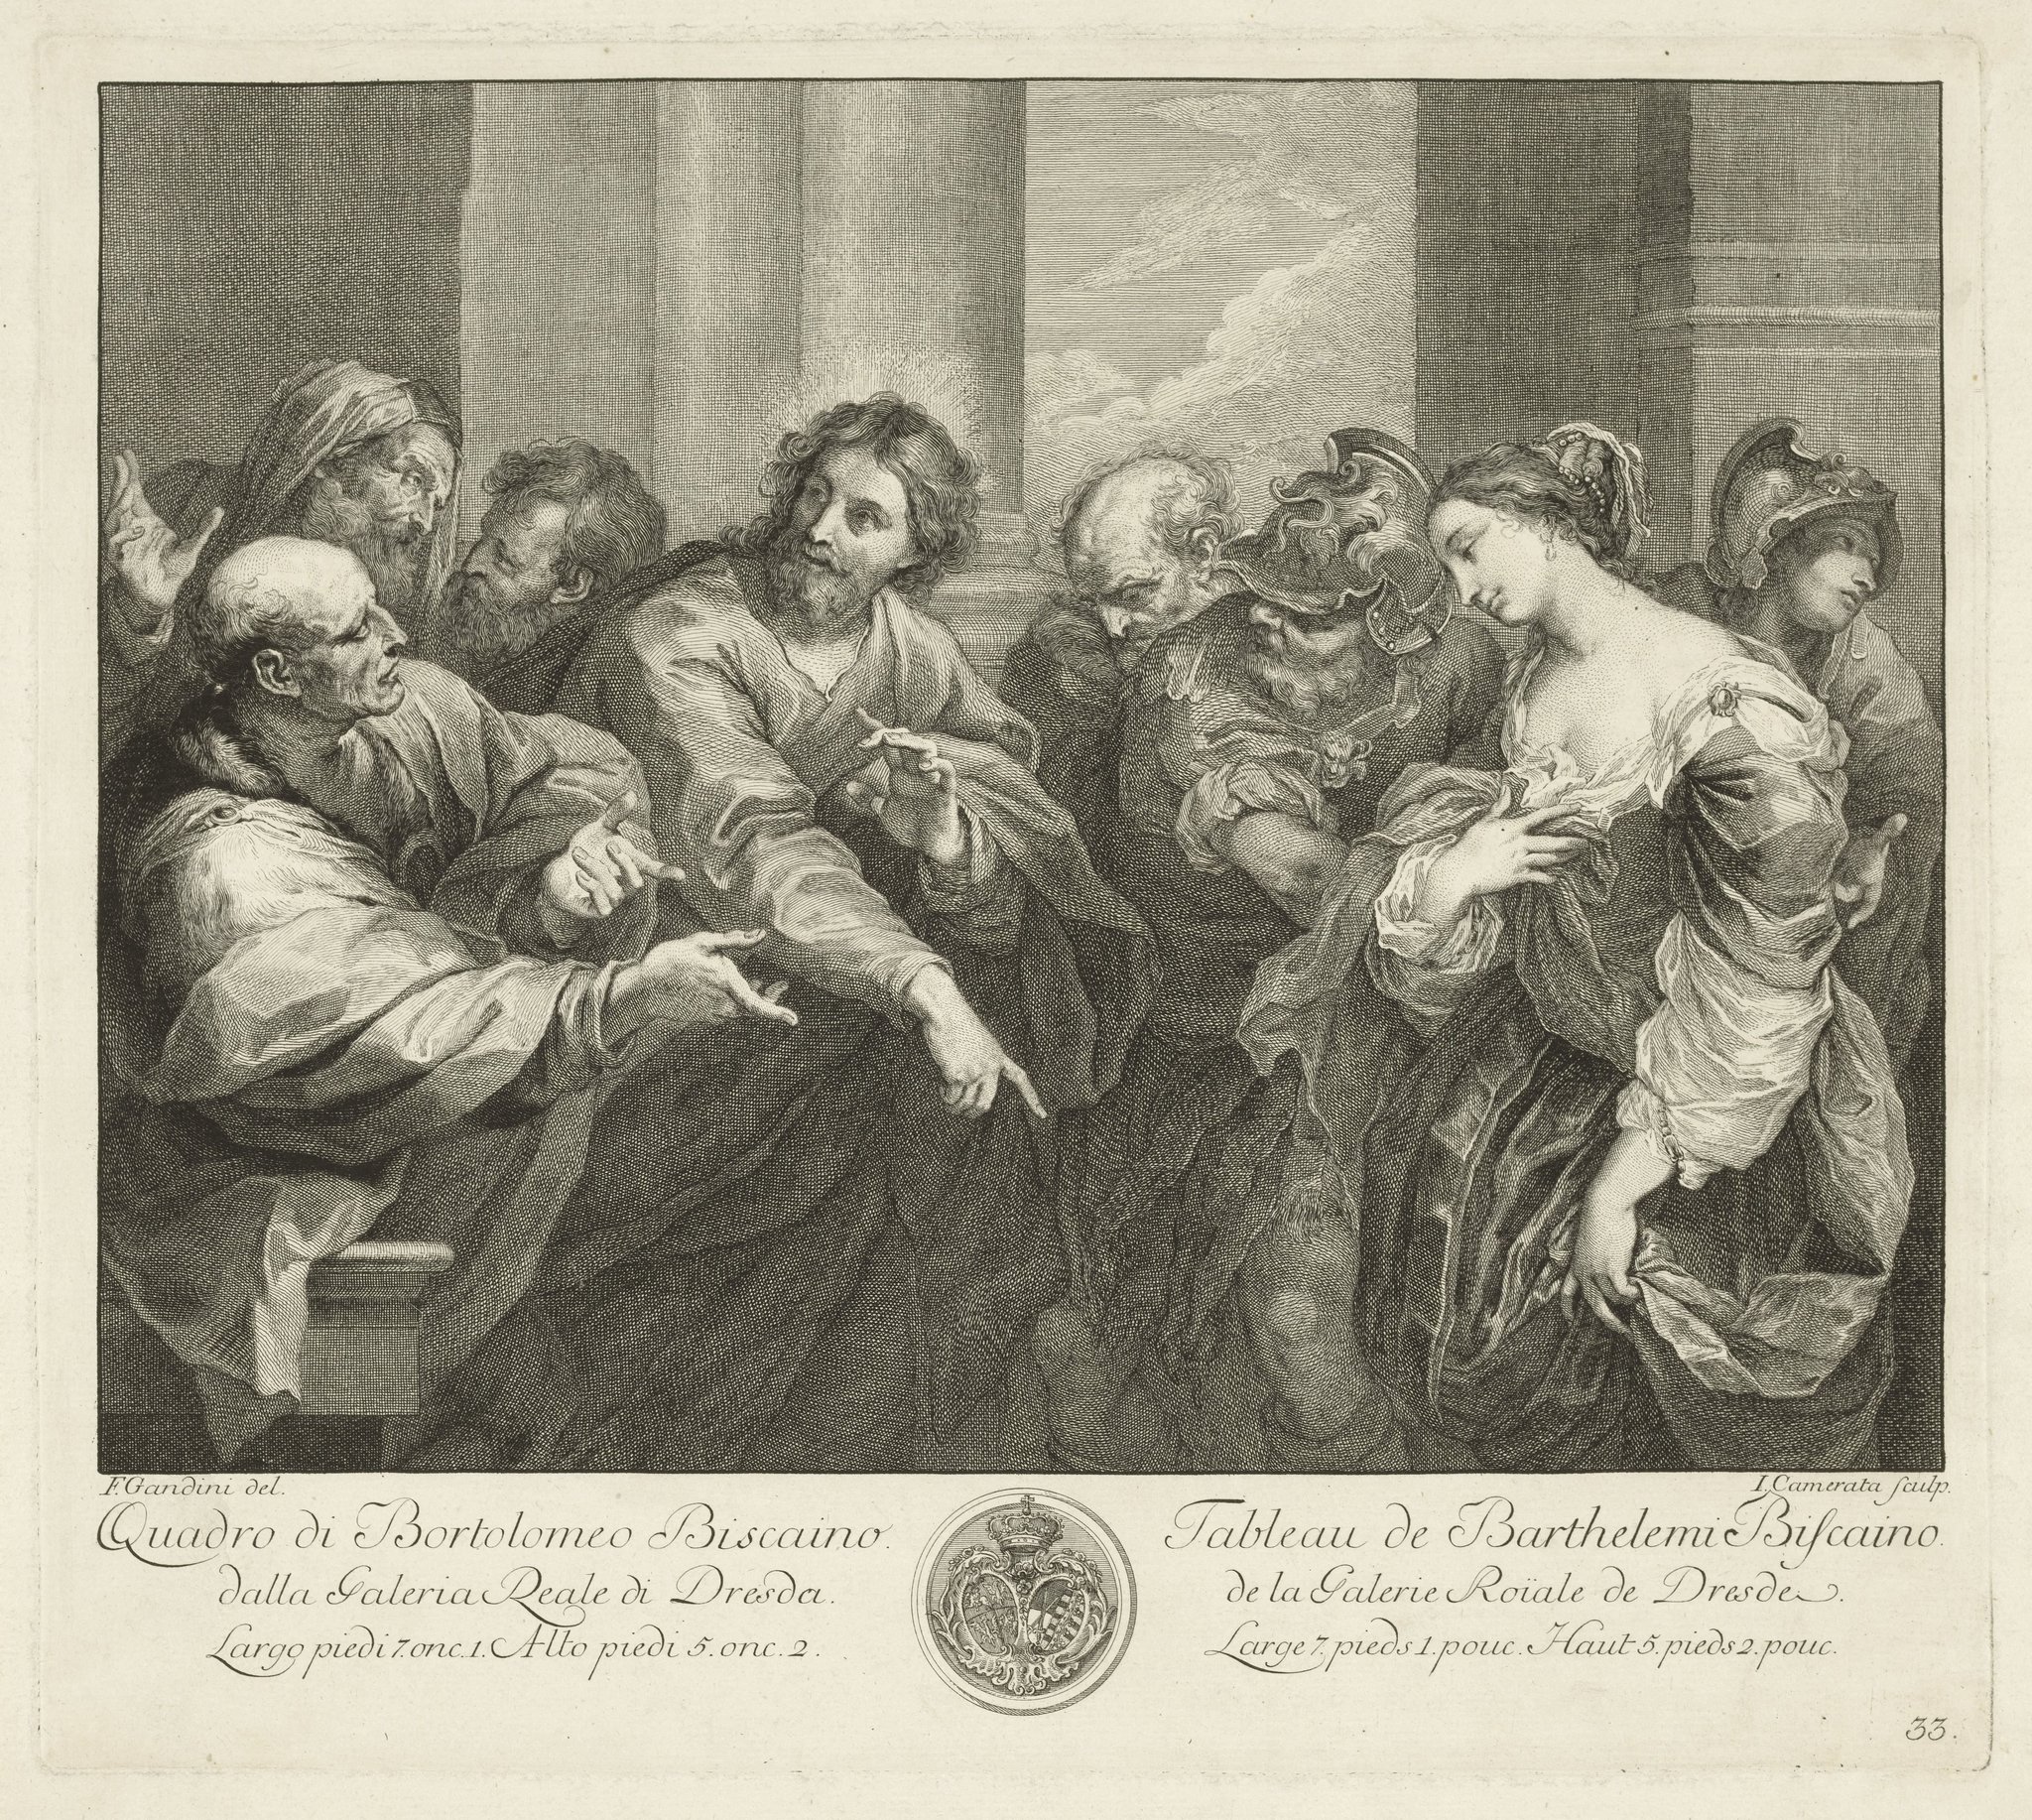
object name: print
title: Christus en de overspelige vrouw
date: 1728-1803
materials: paper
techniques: engraving, etching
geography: italy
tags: pharisees bring a woman accused of adultery before christ (john 8:2-11)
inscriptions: collector's mark: Lugt 2228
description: De Farizeeën brengen een op overspel betrapte vrouw naar Christus om hem te laten oordelen over haar vergrijp. Christus wijst naar de grond. Tekst en wapenschild in ondermarge. Genummerd rechtsonder: 33.